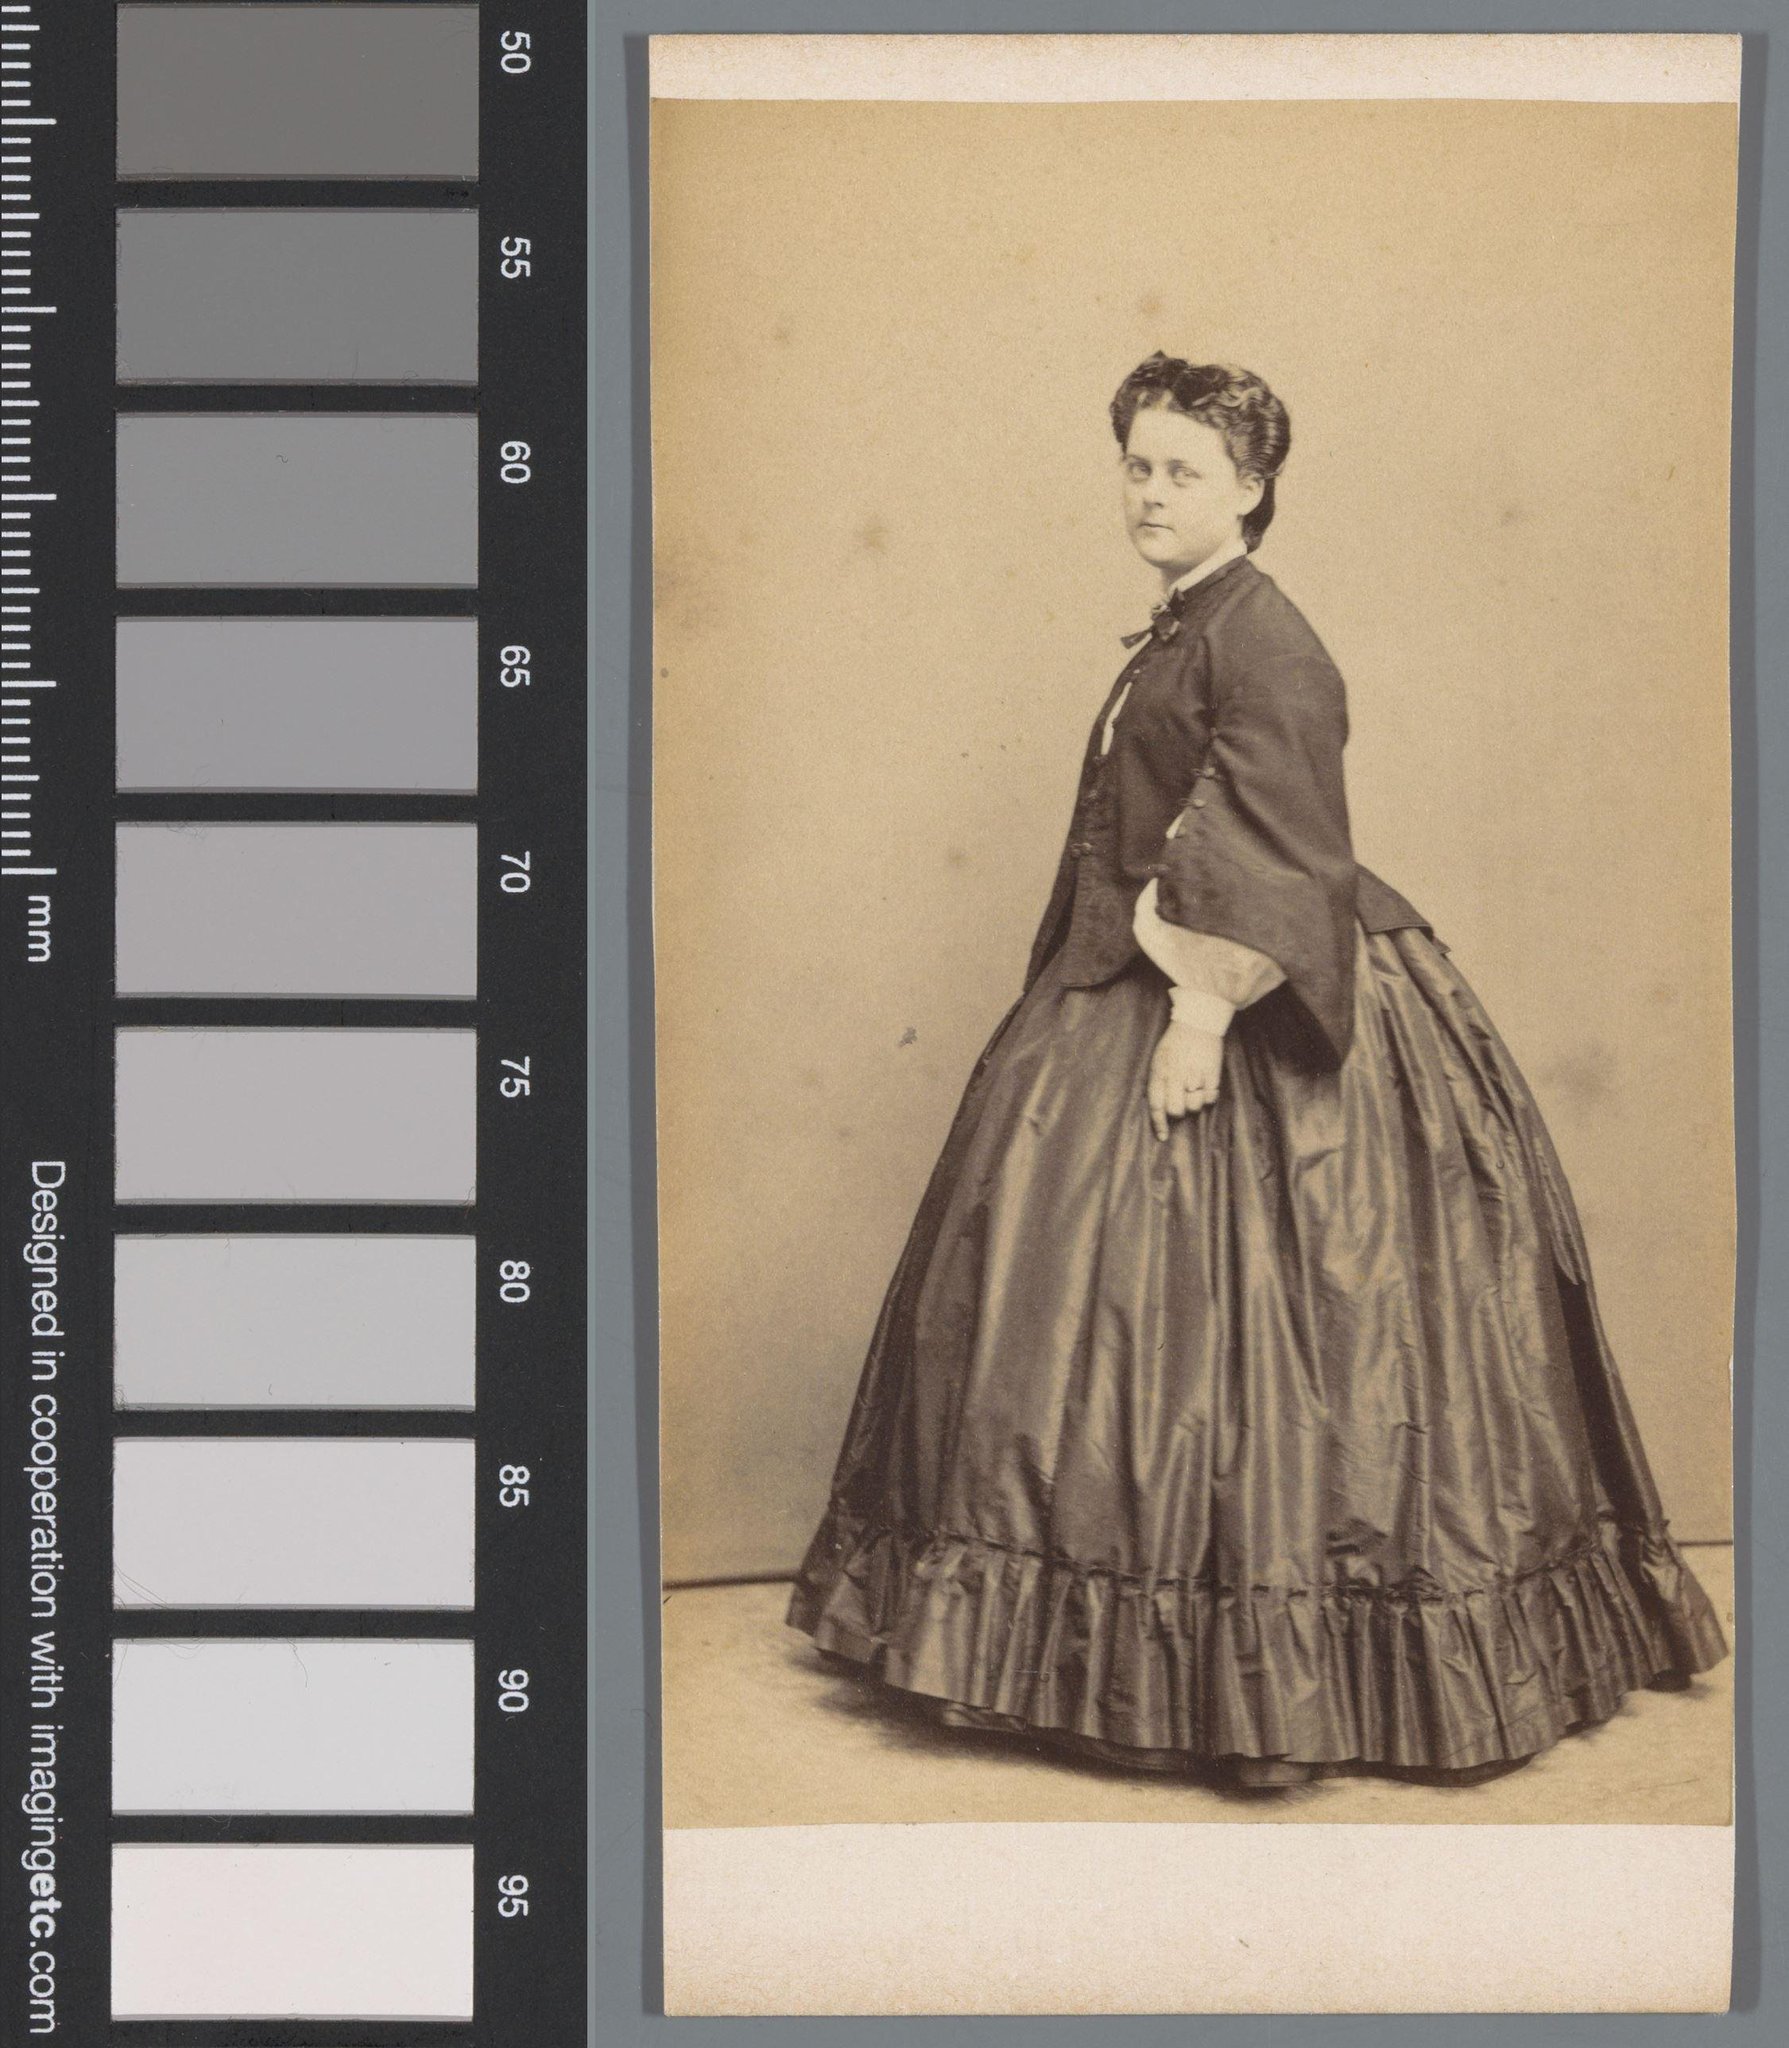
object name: carte de visite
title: Portret van een onbekende vrouw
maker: johann schäfer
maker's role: fotograaf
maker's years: 1822-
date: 1855-1885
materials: cardboard, paper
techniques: albumen print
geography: frankfurt am main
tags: adult woman, anonymous historical person portrayed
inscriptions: inscription: ‘J. Schäfer/ Photograph/ Frankfurt a. M.’